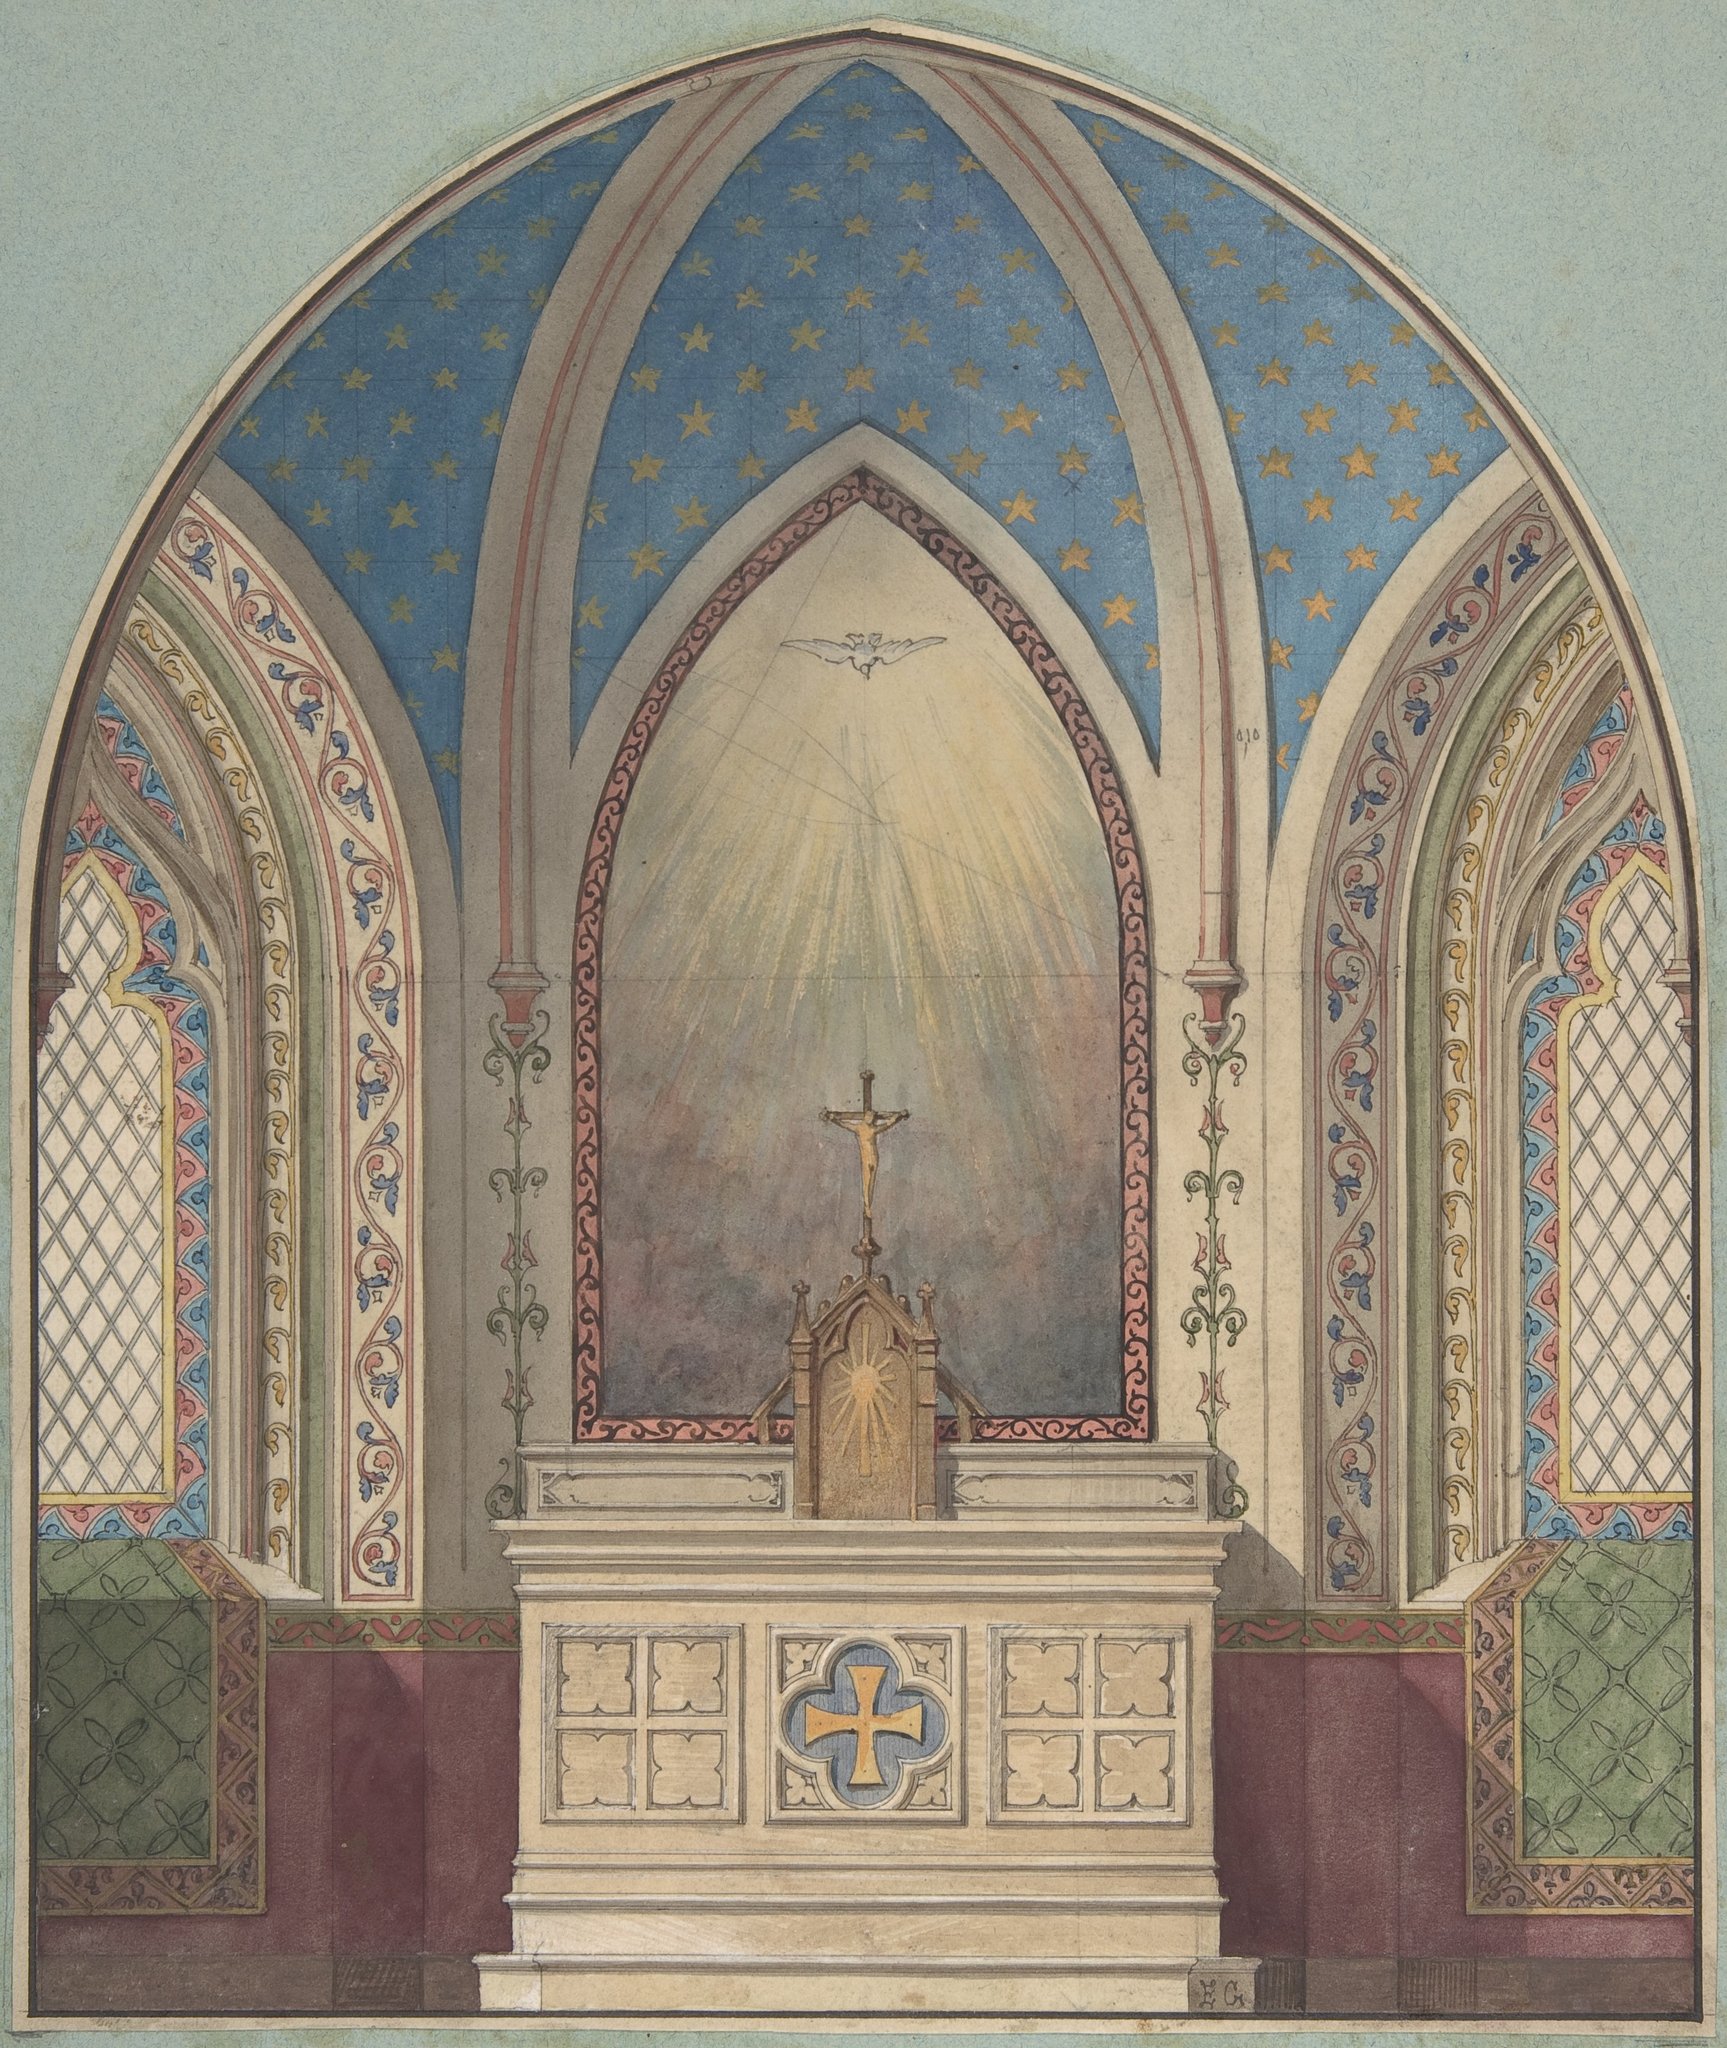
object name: drawing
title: Design for Altar, Saint Clotilde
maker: jules-edmond-charles lachaise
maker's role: artist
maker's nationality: french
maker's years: 1897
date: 1851-1900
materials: gilt, gouache, graphite, ink, watercolor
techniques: pen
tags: architecture,altars